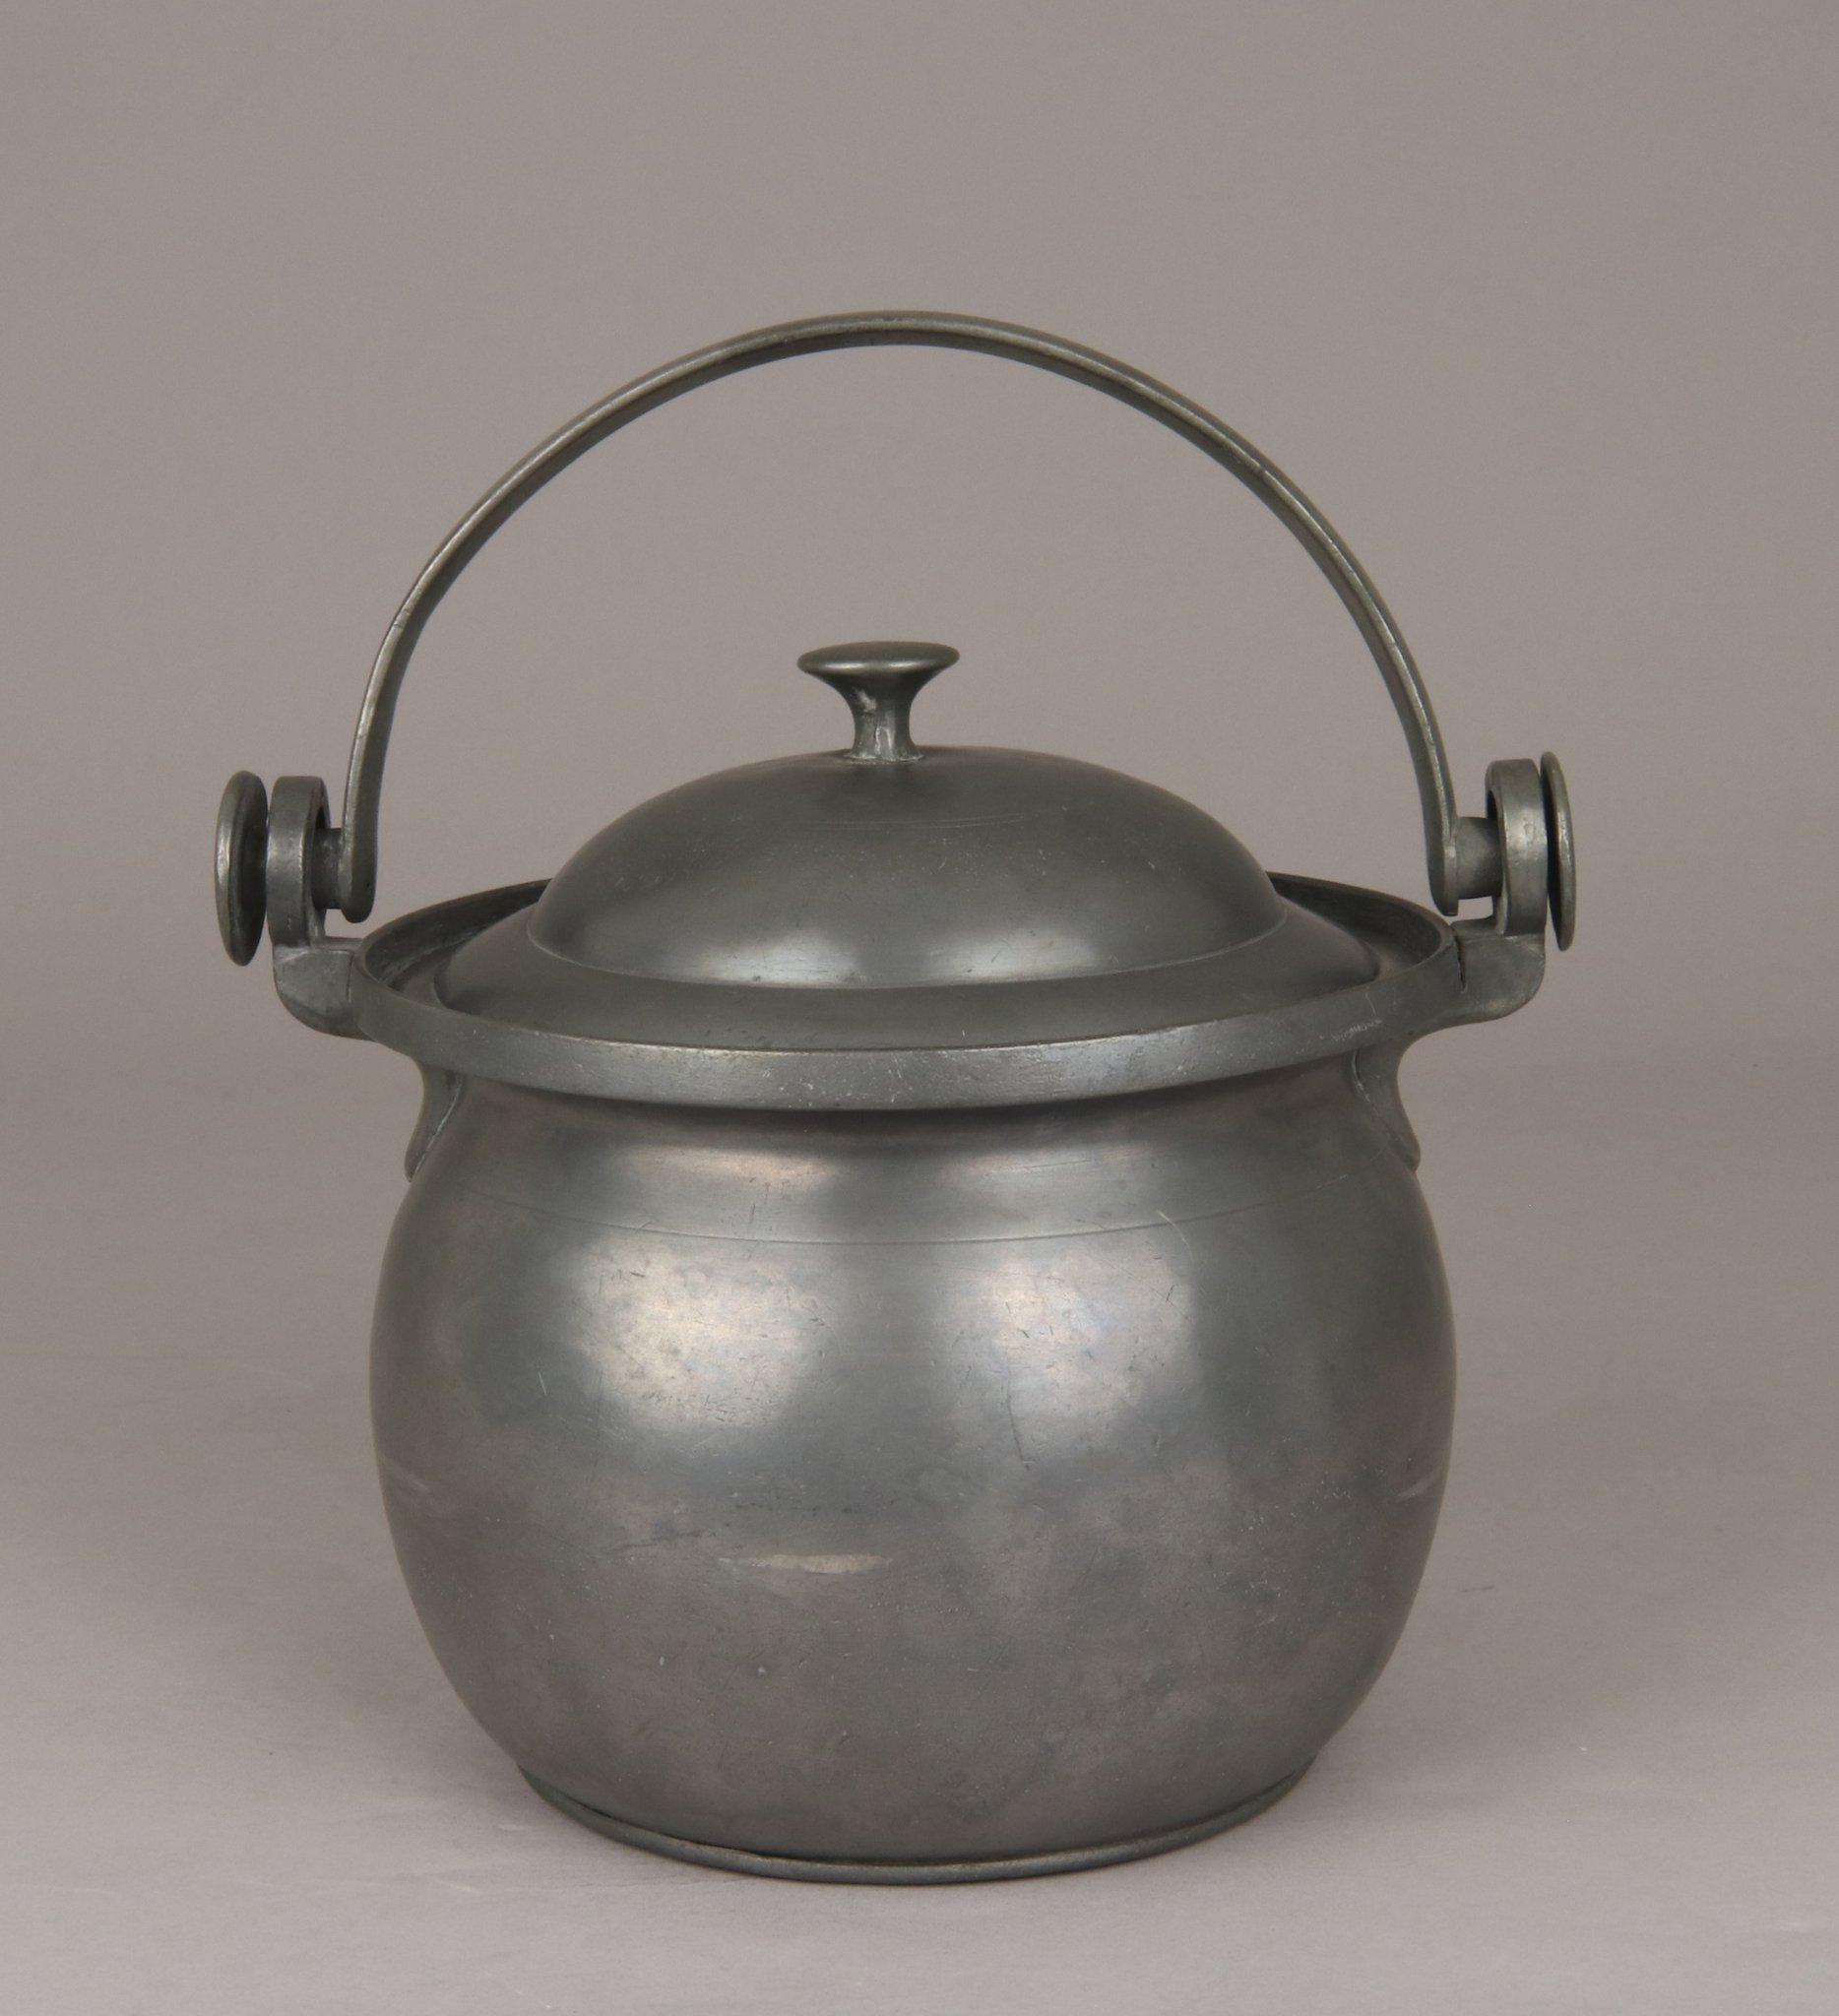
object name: dinner pail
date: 1767-1833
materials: pewter